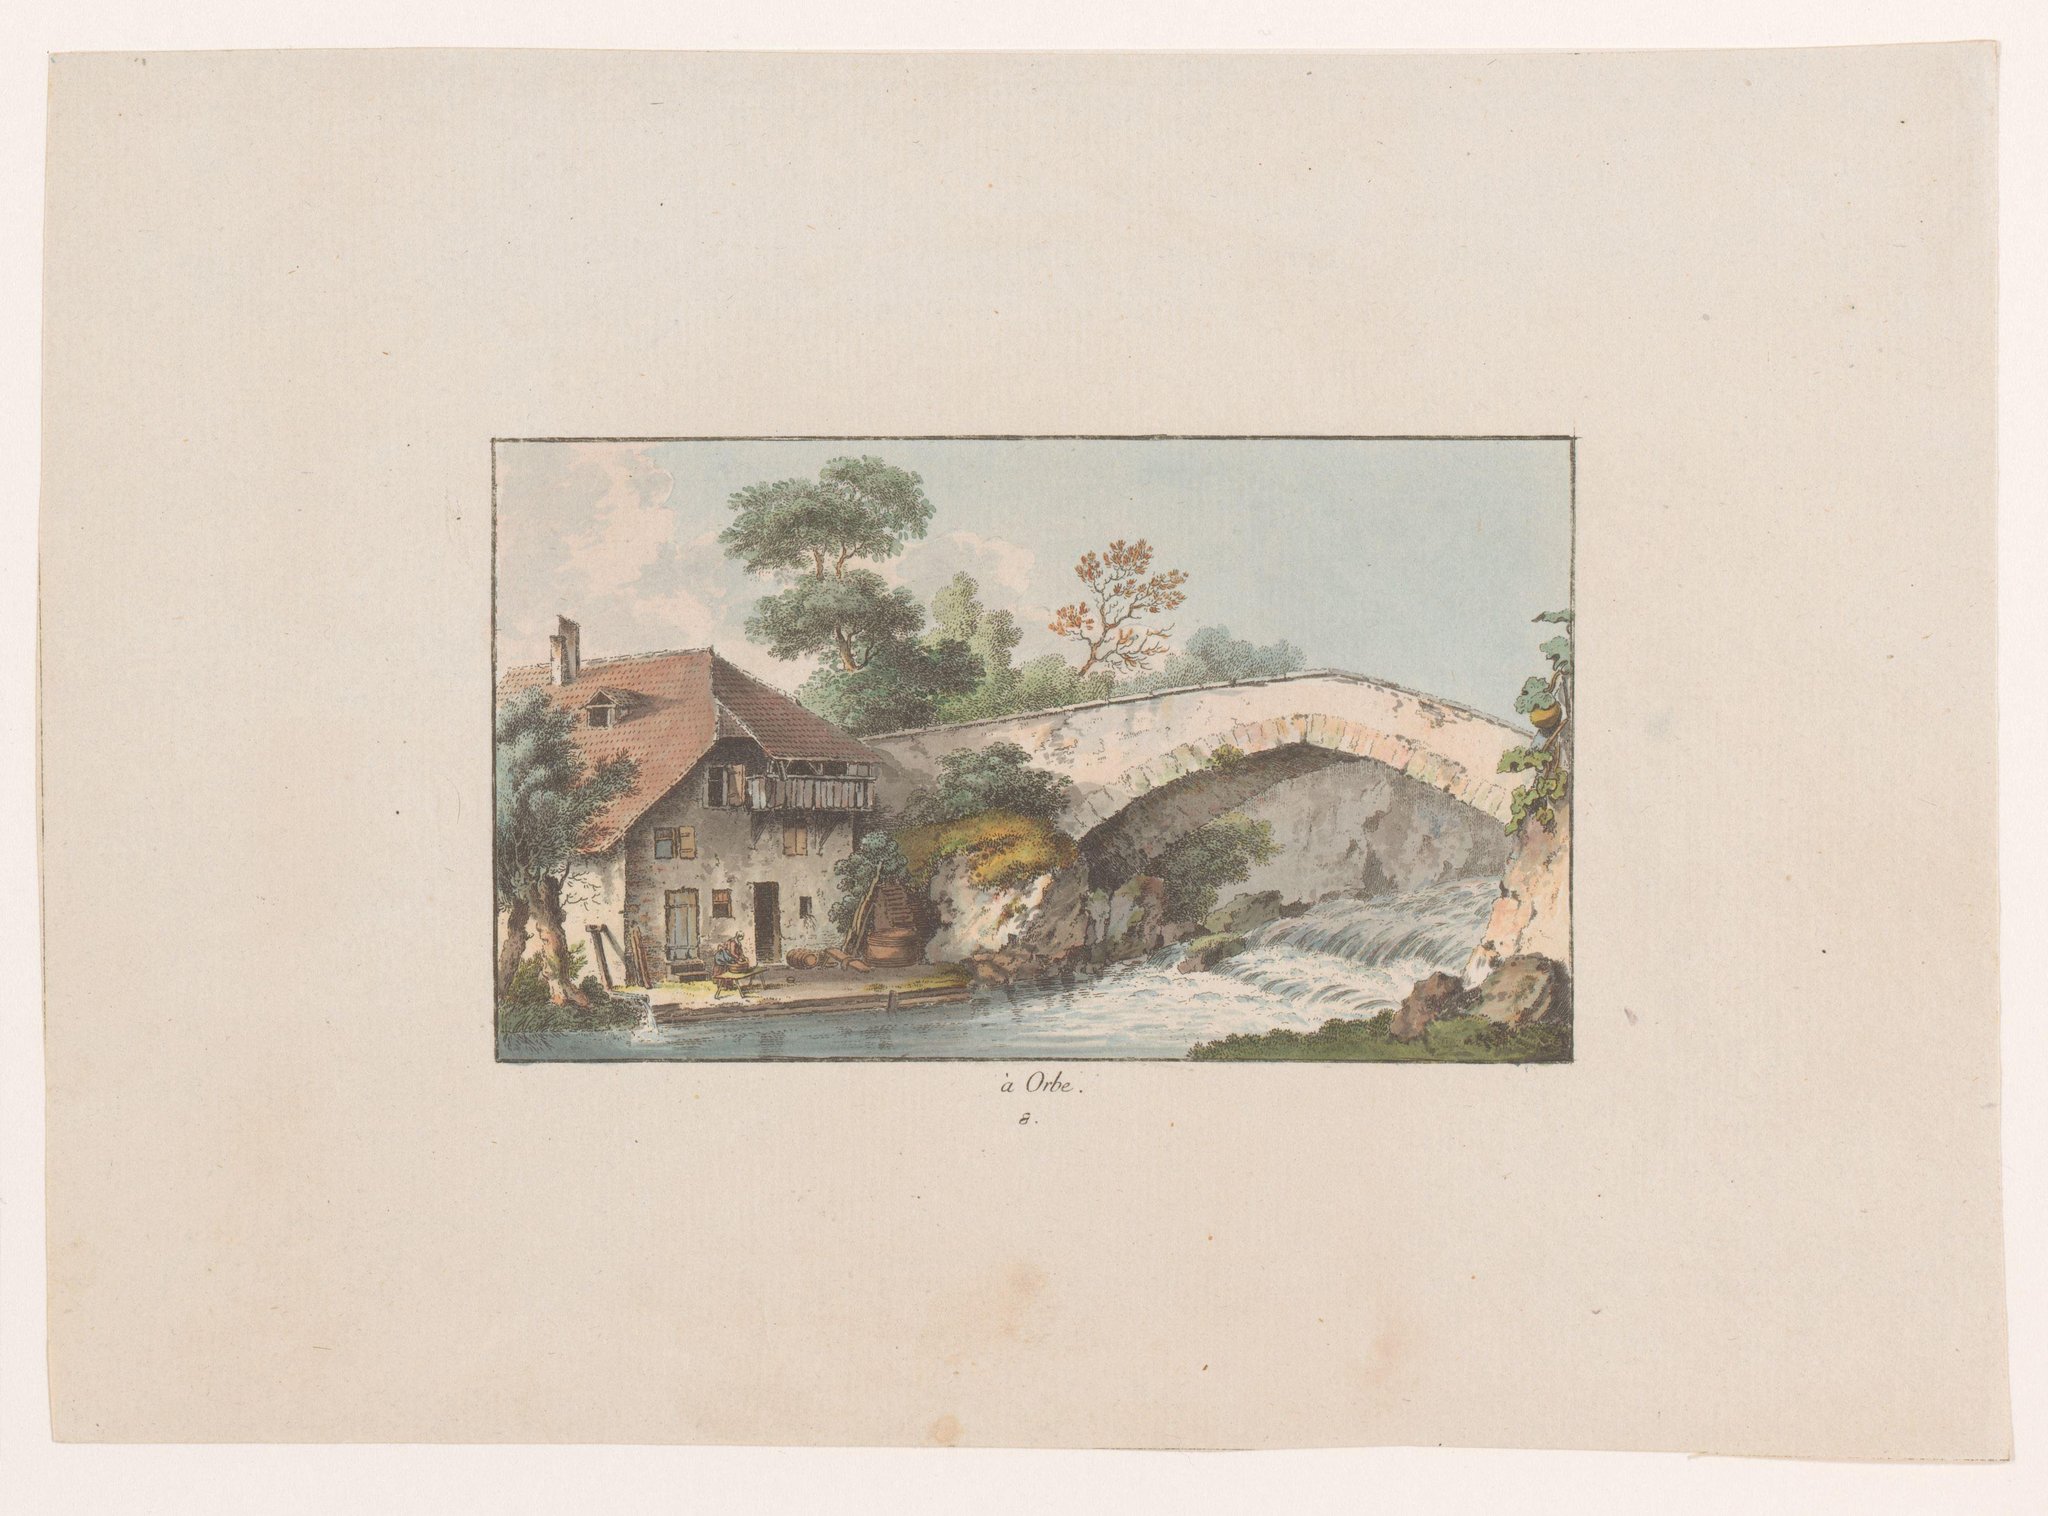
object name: print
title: Collection de quelques vues dessinées en Suisse d'après nature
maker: heinrich rieter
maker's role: print maker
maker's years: 1751-1818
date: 1782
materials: paper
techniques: etching, hand coloring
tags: rapids, bridge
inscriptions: watermark, collector's mark: Lugt 2228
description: Maakt deel uit van een serie met gezichten op Zwitserland.